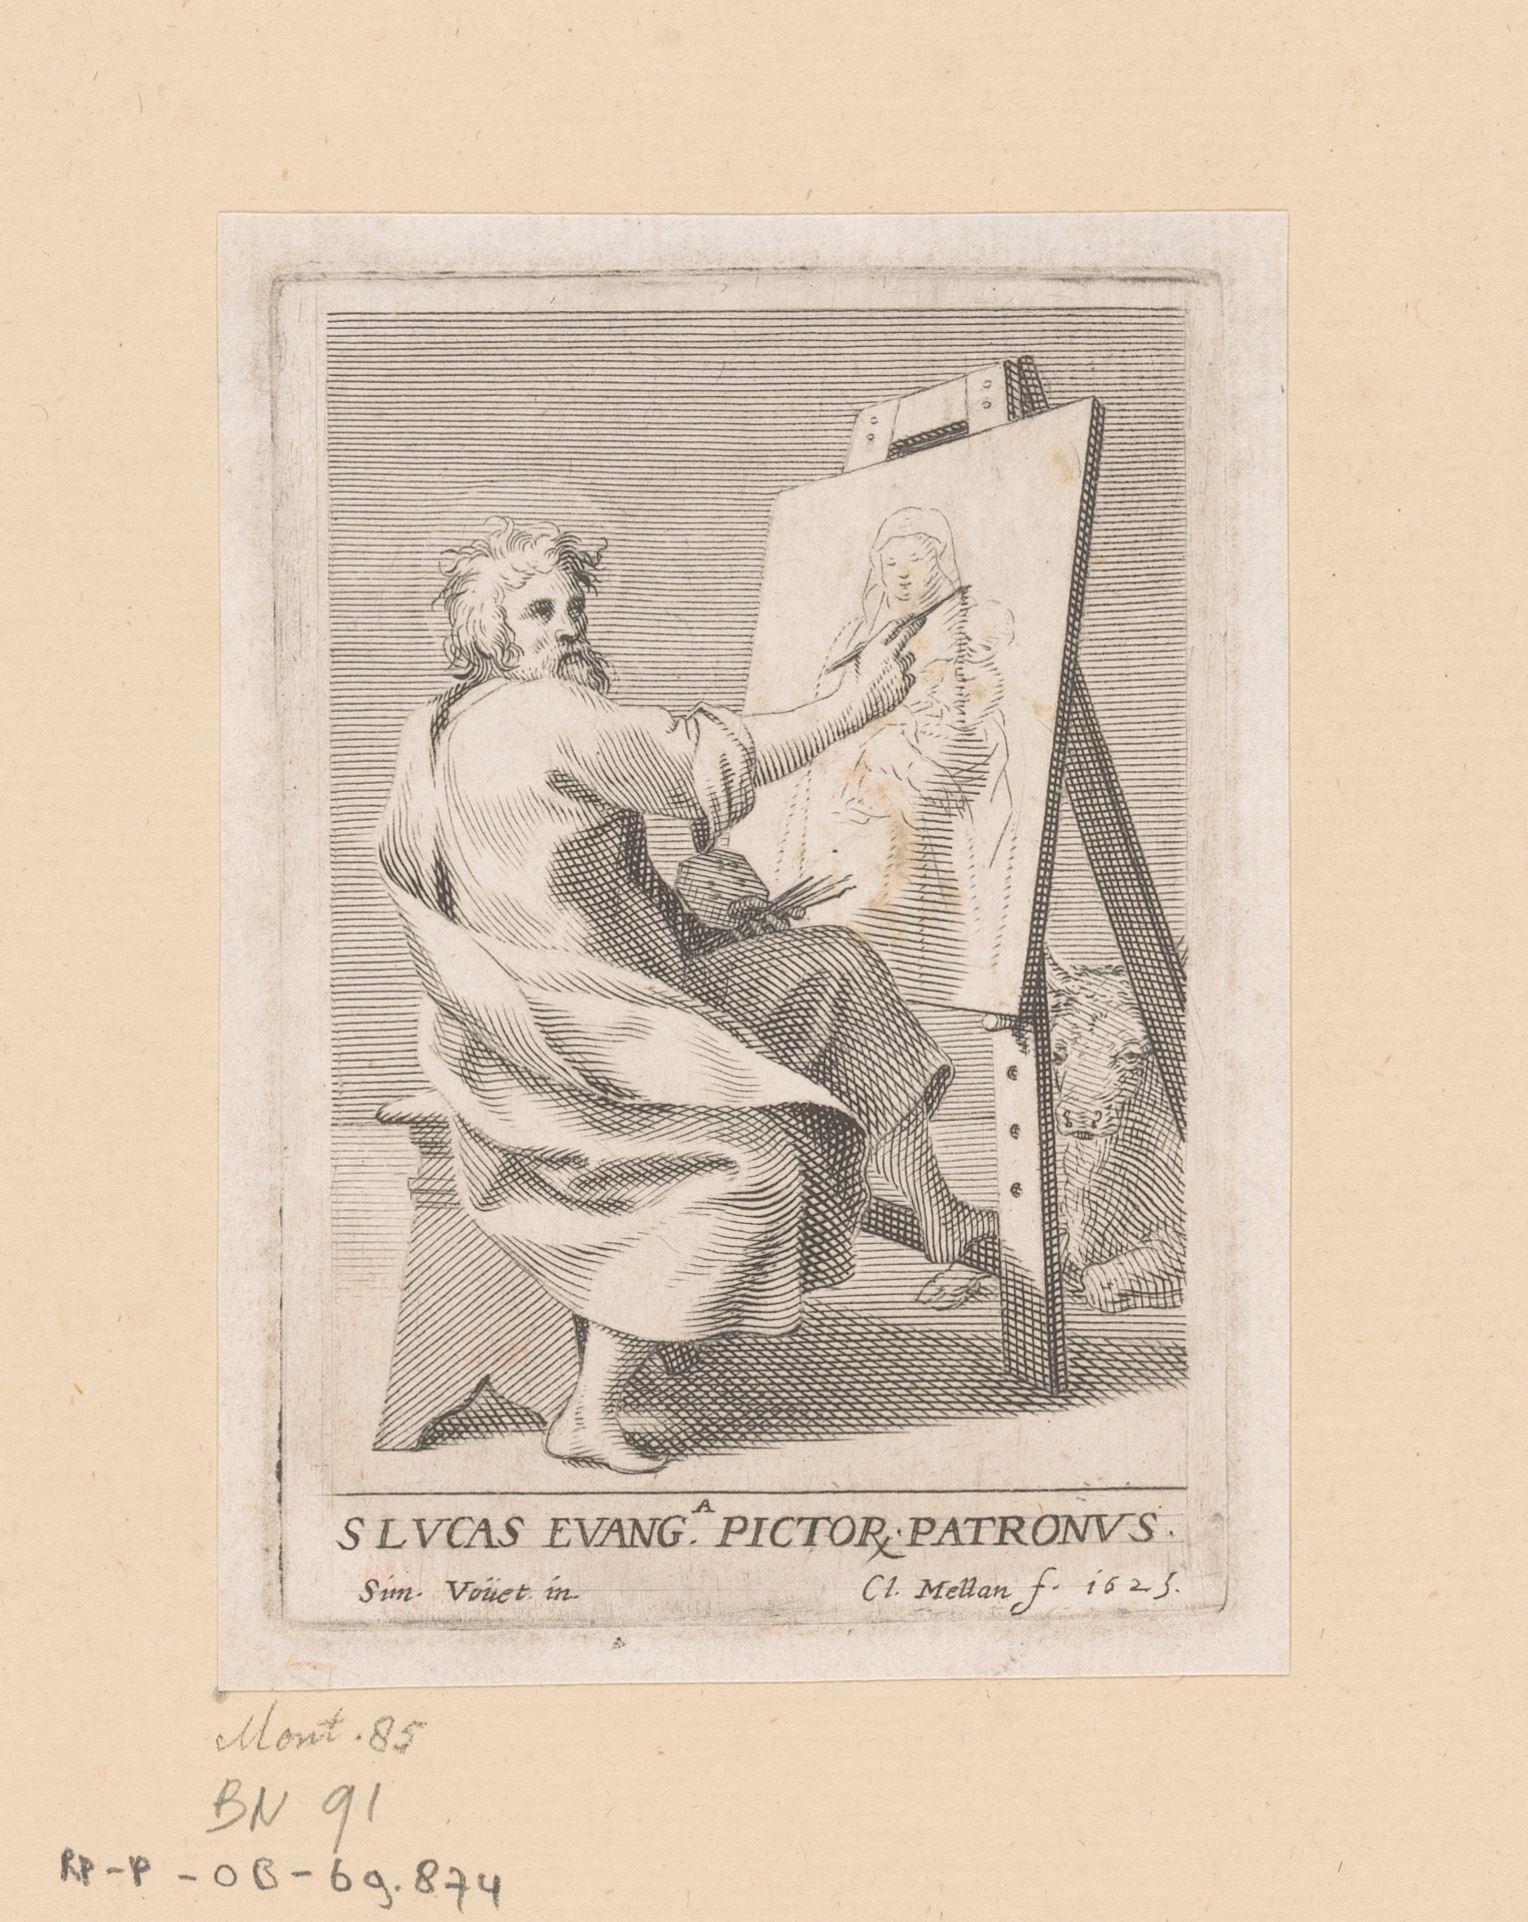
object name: print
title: Heilige Lucas schildert Maria met kind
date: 1625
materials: paper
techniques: engraving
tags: st.luke painting or drawing the madonna (i.e. mary and the christ-child), sometimes joseph present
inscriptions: collector's mark: Lugt 240